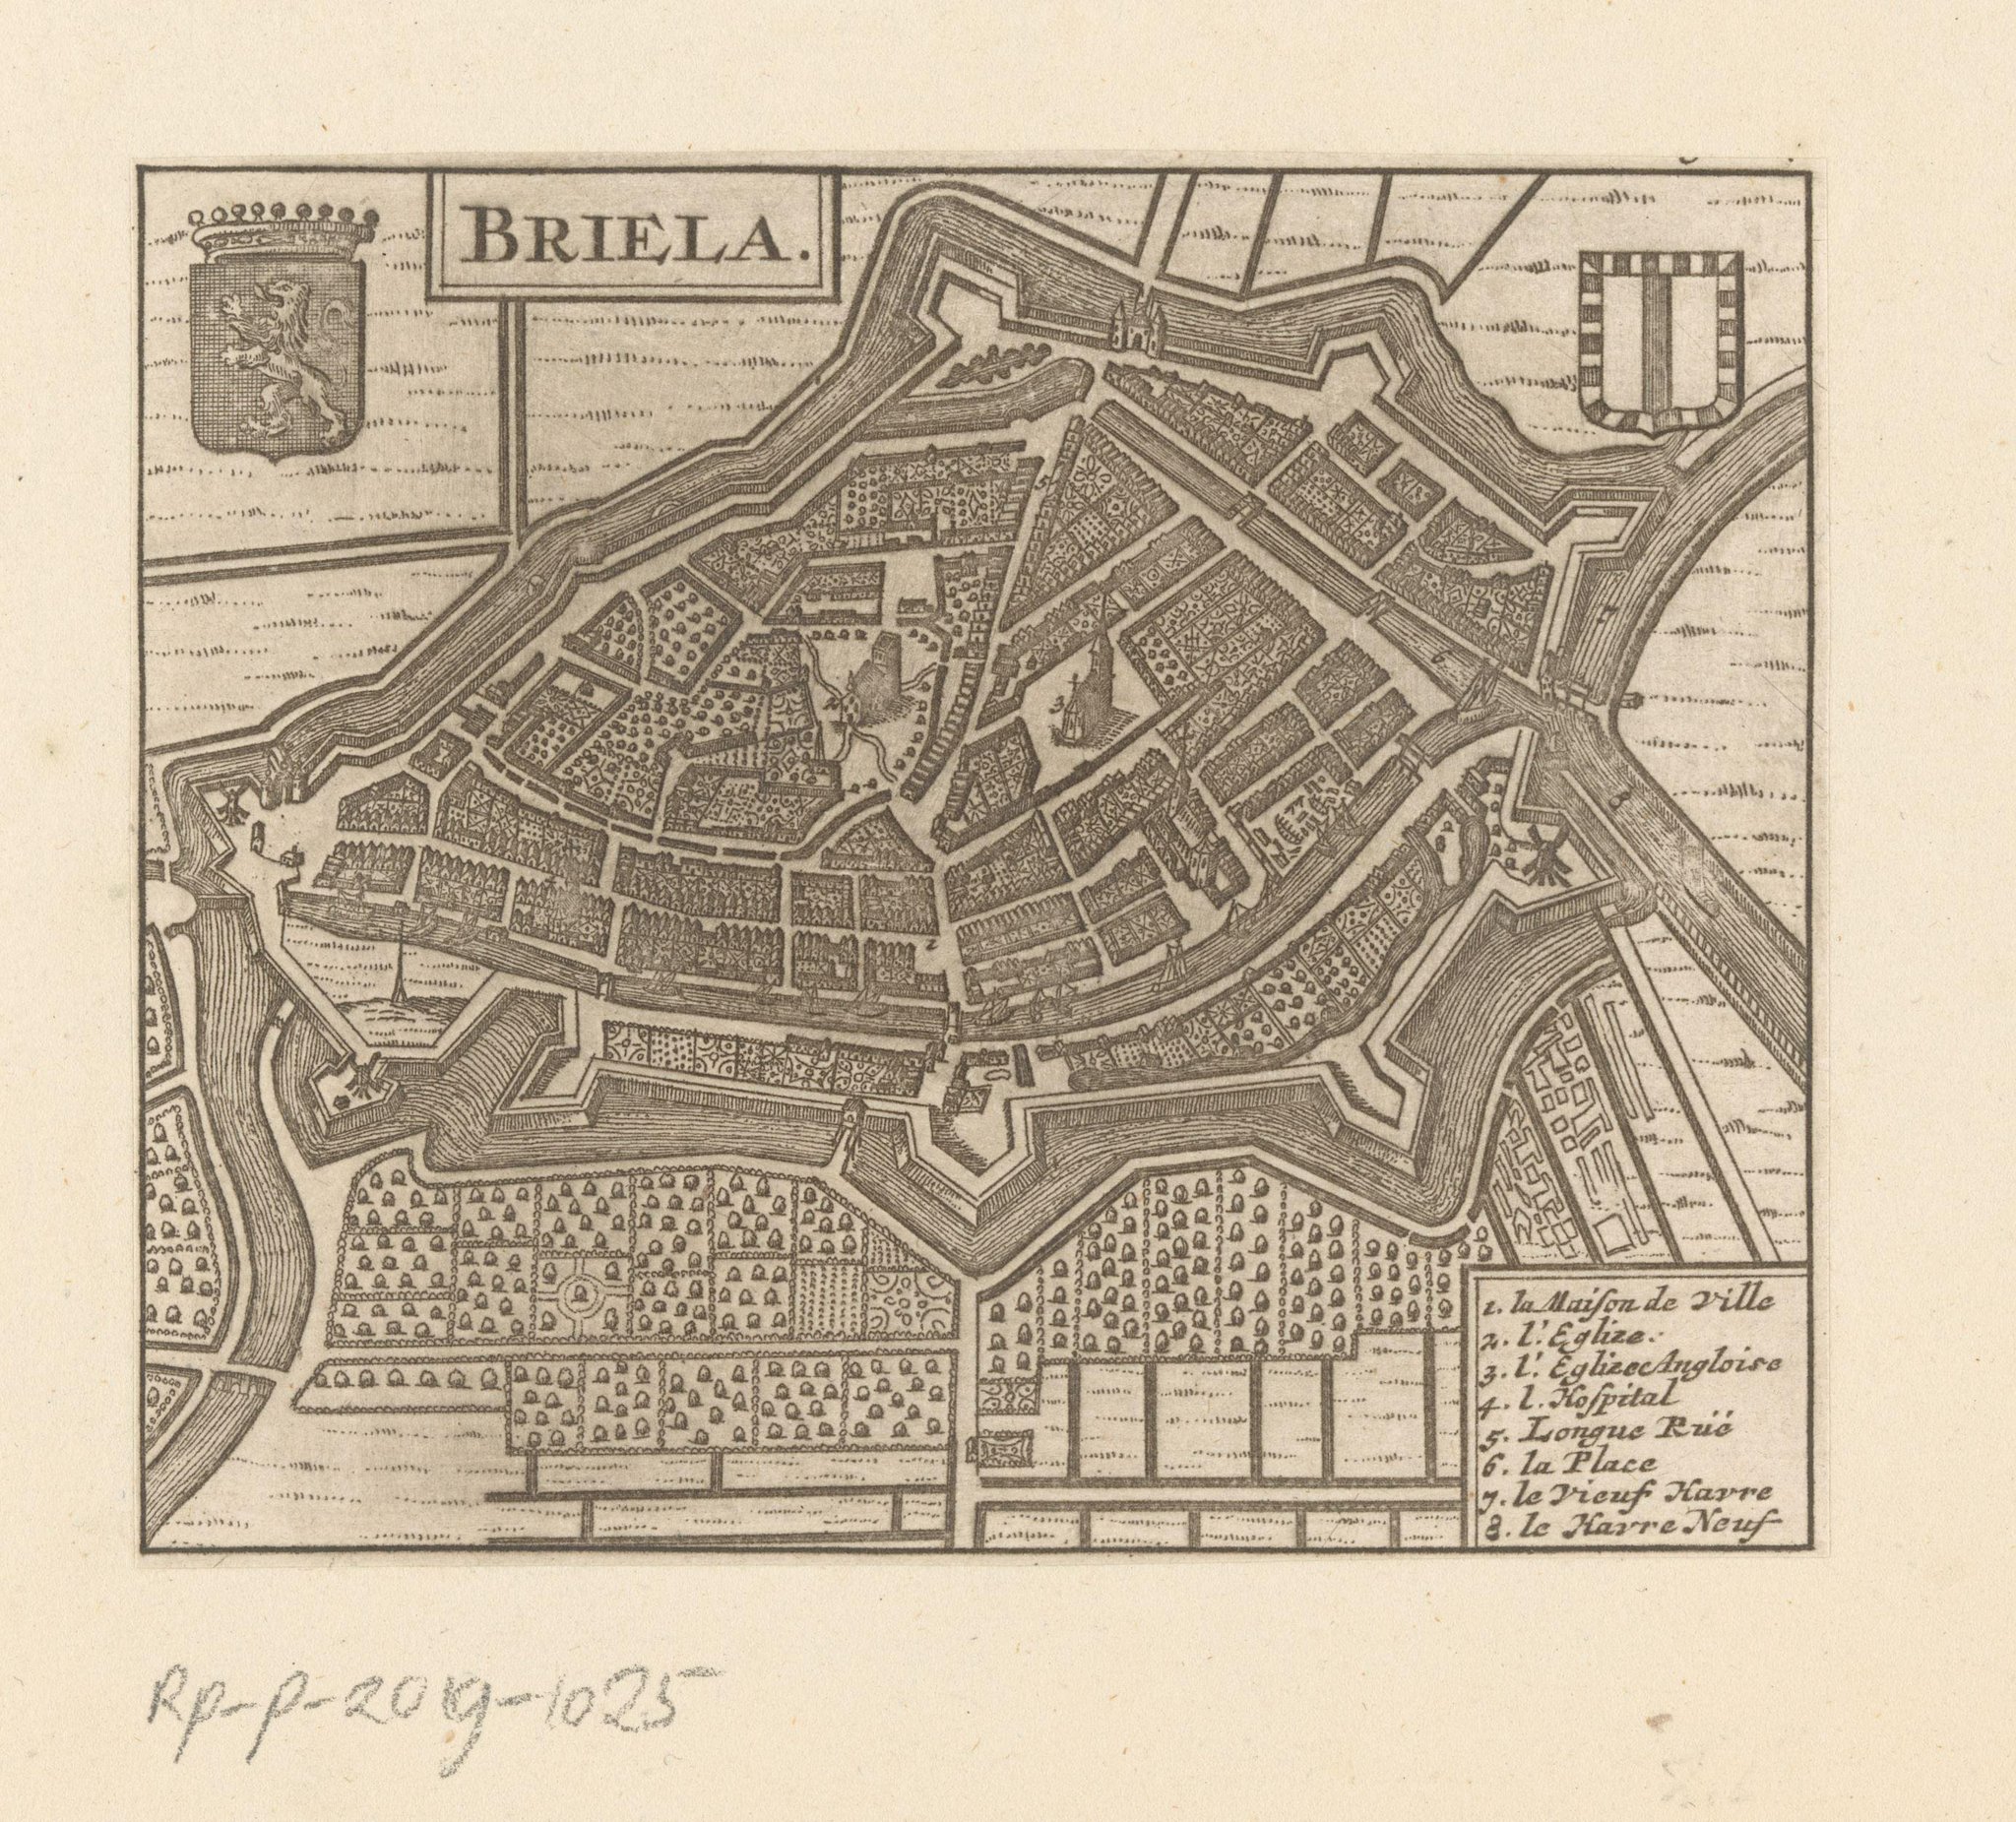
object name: print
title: Plattegrond van Brielle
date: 1685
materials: paper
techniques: etching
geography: amsterdam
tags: maps of cities, brielle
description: Prent uit: Parival, Nicolas-Jean de. Les delices de la Hollande (...). Amsterdam: Abraham Wolfgang, 1685.